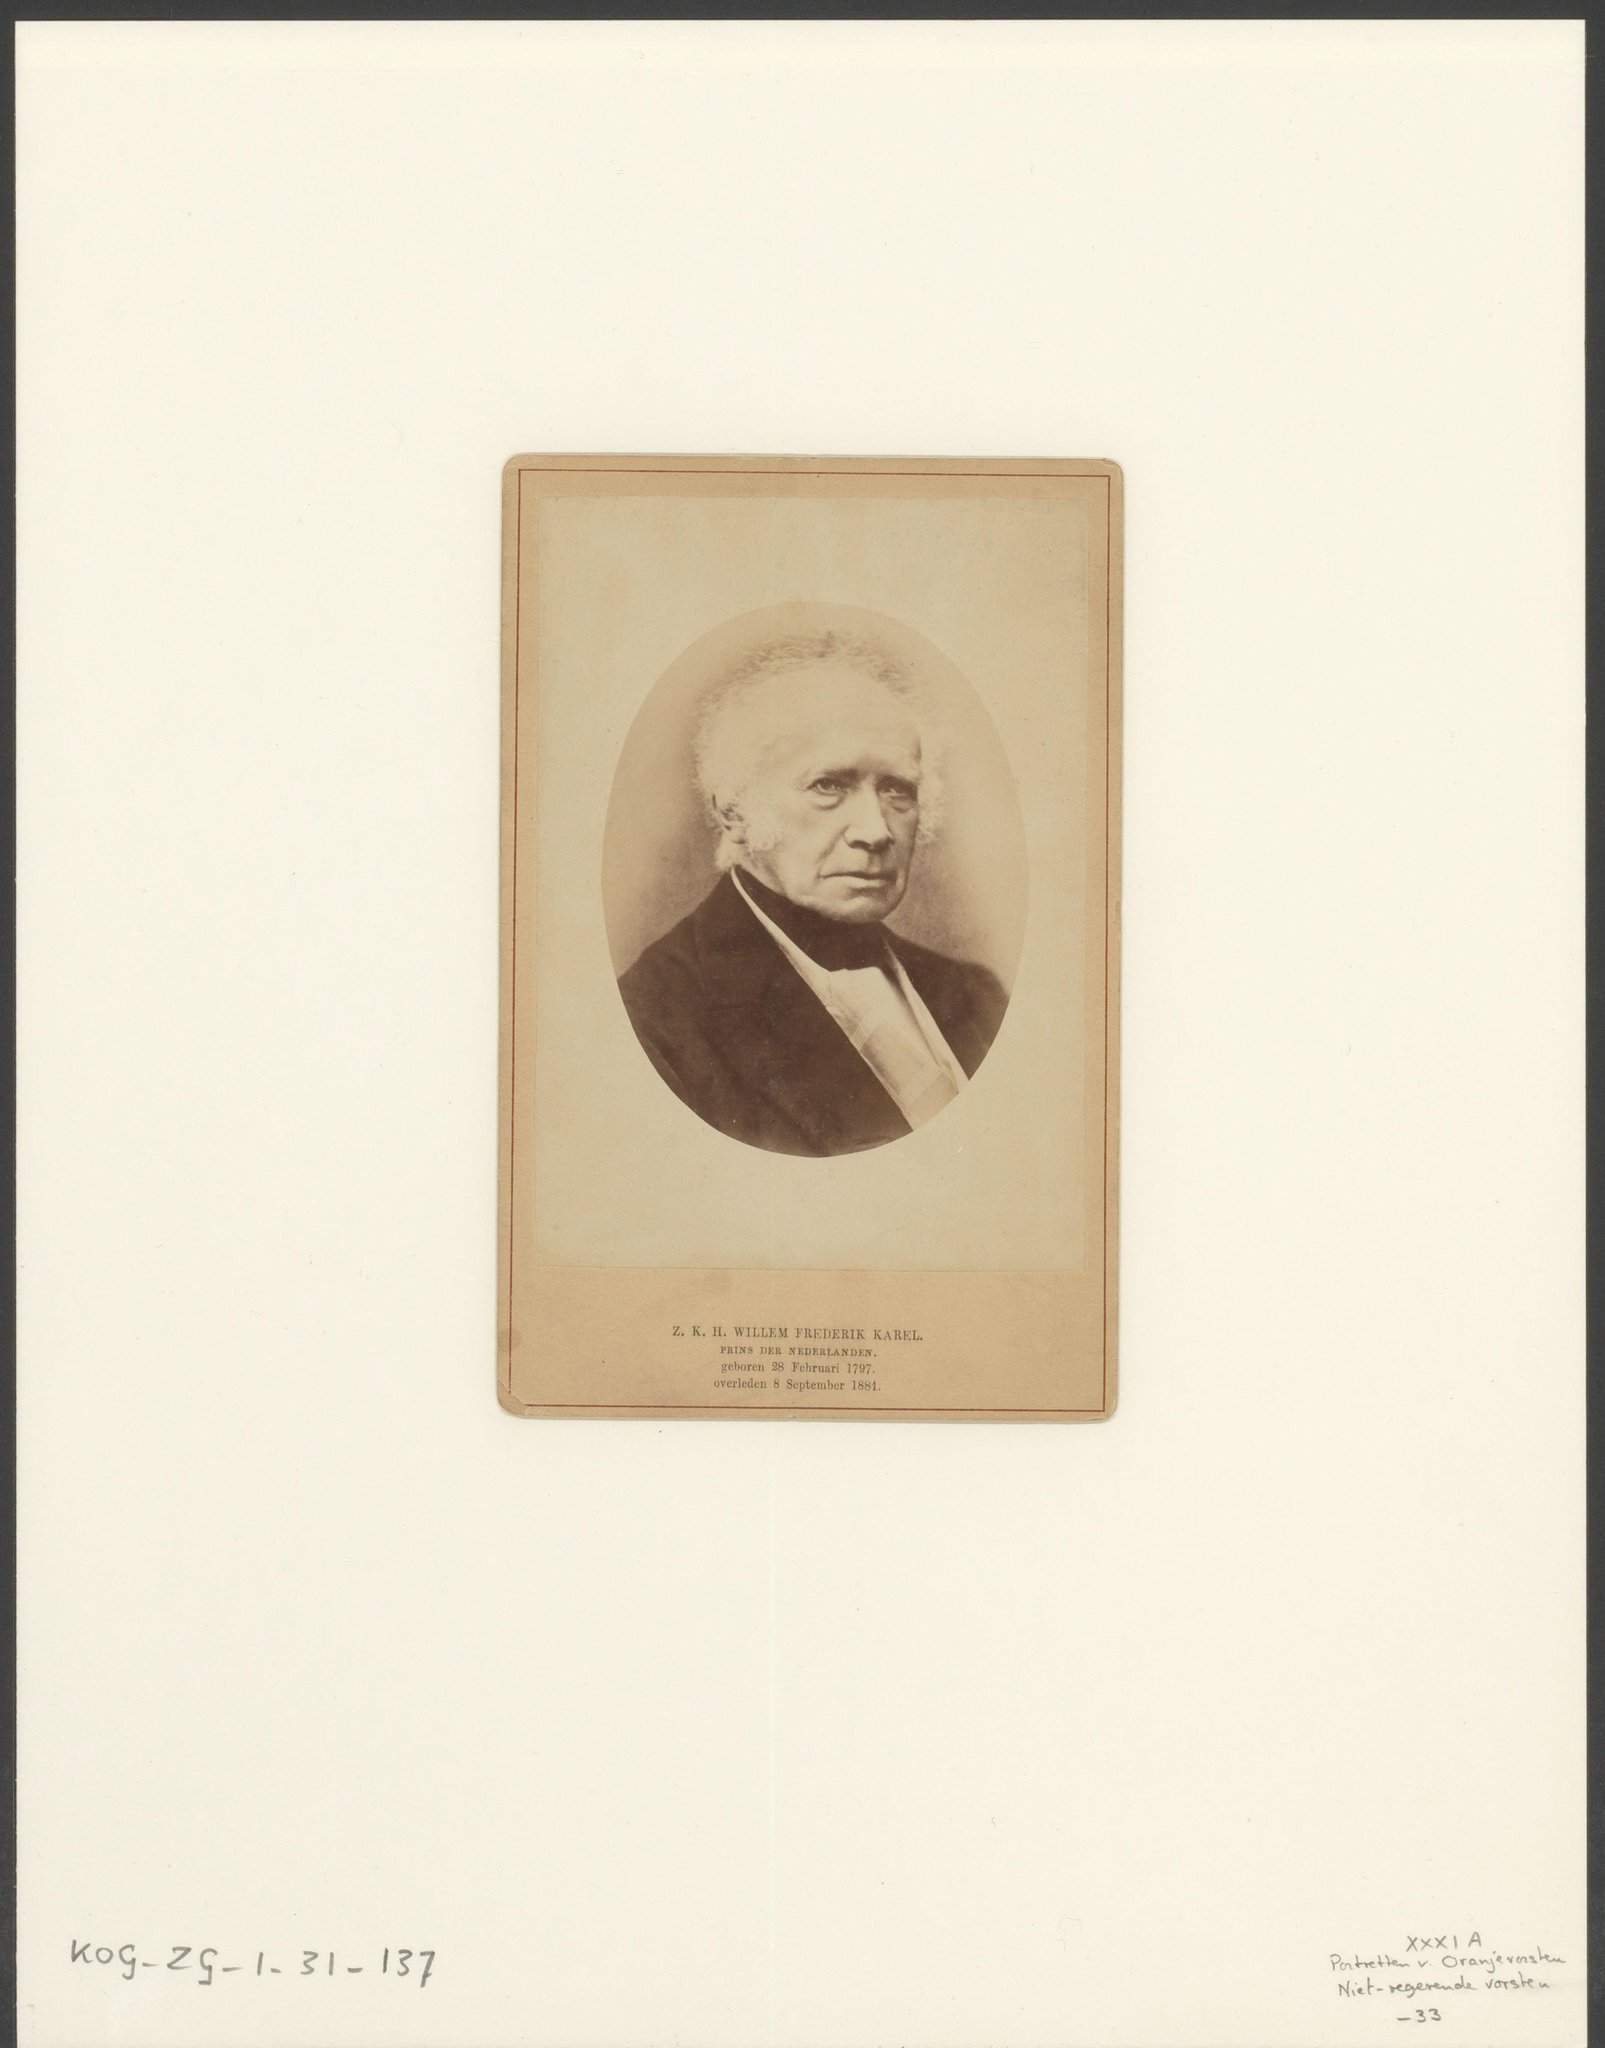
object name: photograph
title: Portret van Frederik, prins der Nederlanden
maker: Anonymous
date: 1881-1883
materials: cardboard, paper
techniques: albumen print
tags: berlin, frederik (prins der nederlanden), historical persons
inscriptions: collector's mark: Lugt 1641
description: Onderwerpsrubrieken binnen de Atlas Zeden en Gewoonten: Portretten, Portretten van Vorsten uit het huis van Oranje, Niet regeerende Vorsten.